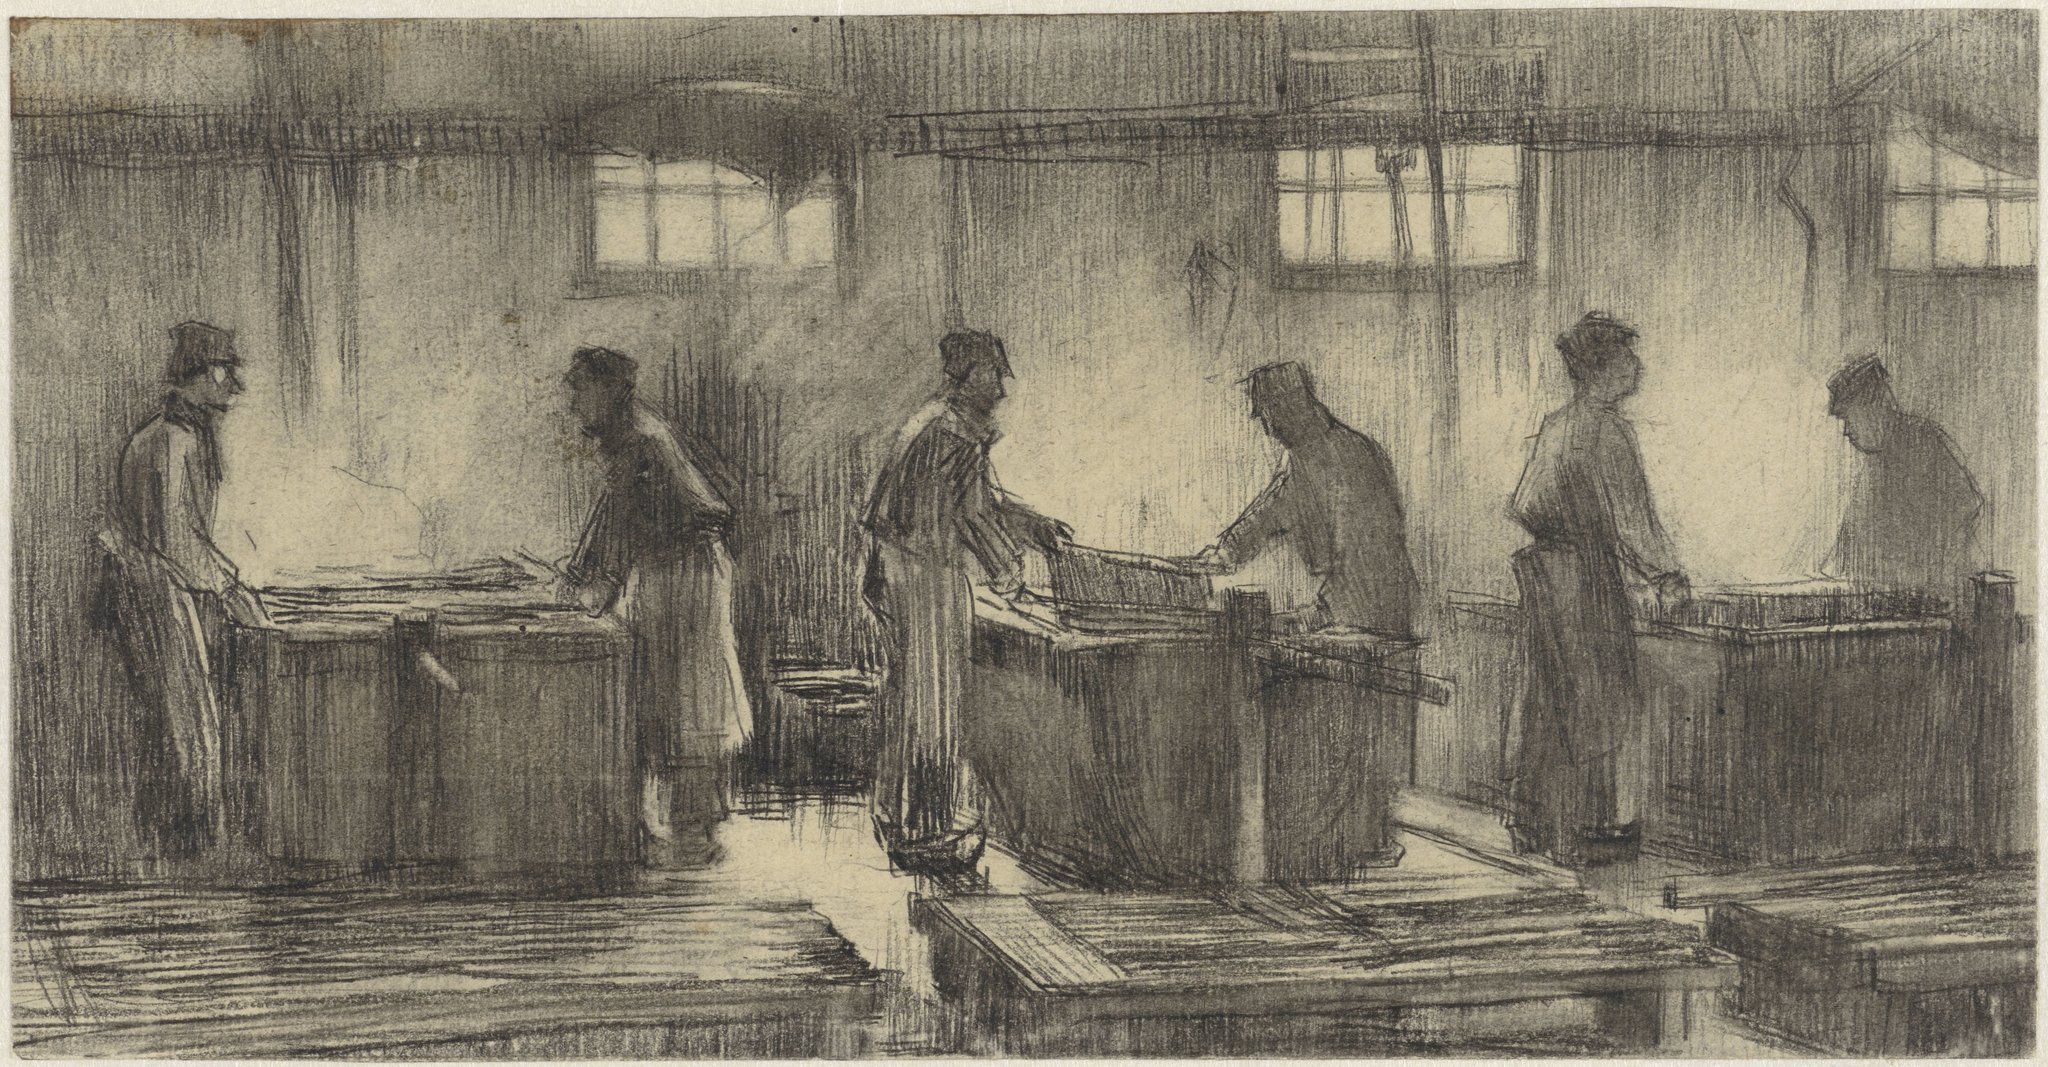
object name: drawing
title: De krabbers in de katoenververij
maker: anthon gerhard alexander van rappard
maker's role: draughtsman, print maker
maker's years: 1858-1892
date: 1868-1892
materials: charcoal, paper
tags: dyeing of cloth, cotton (material ~ textile industry)